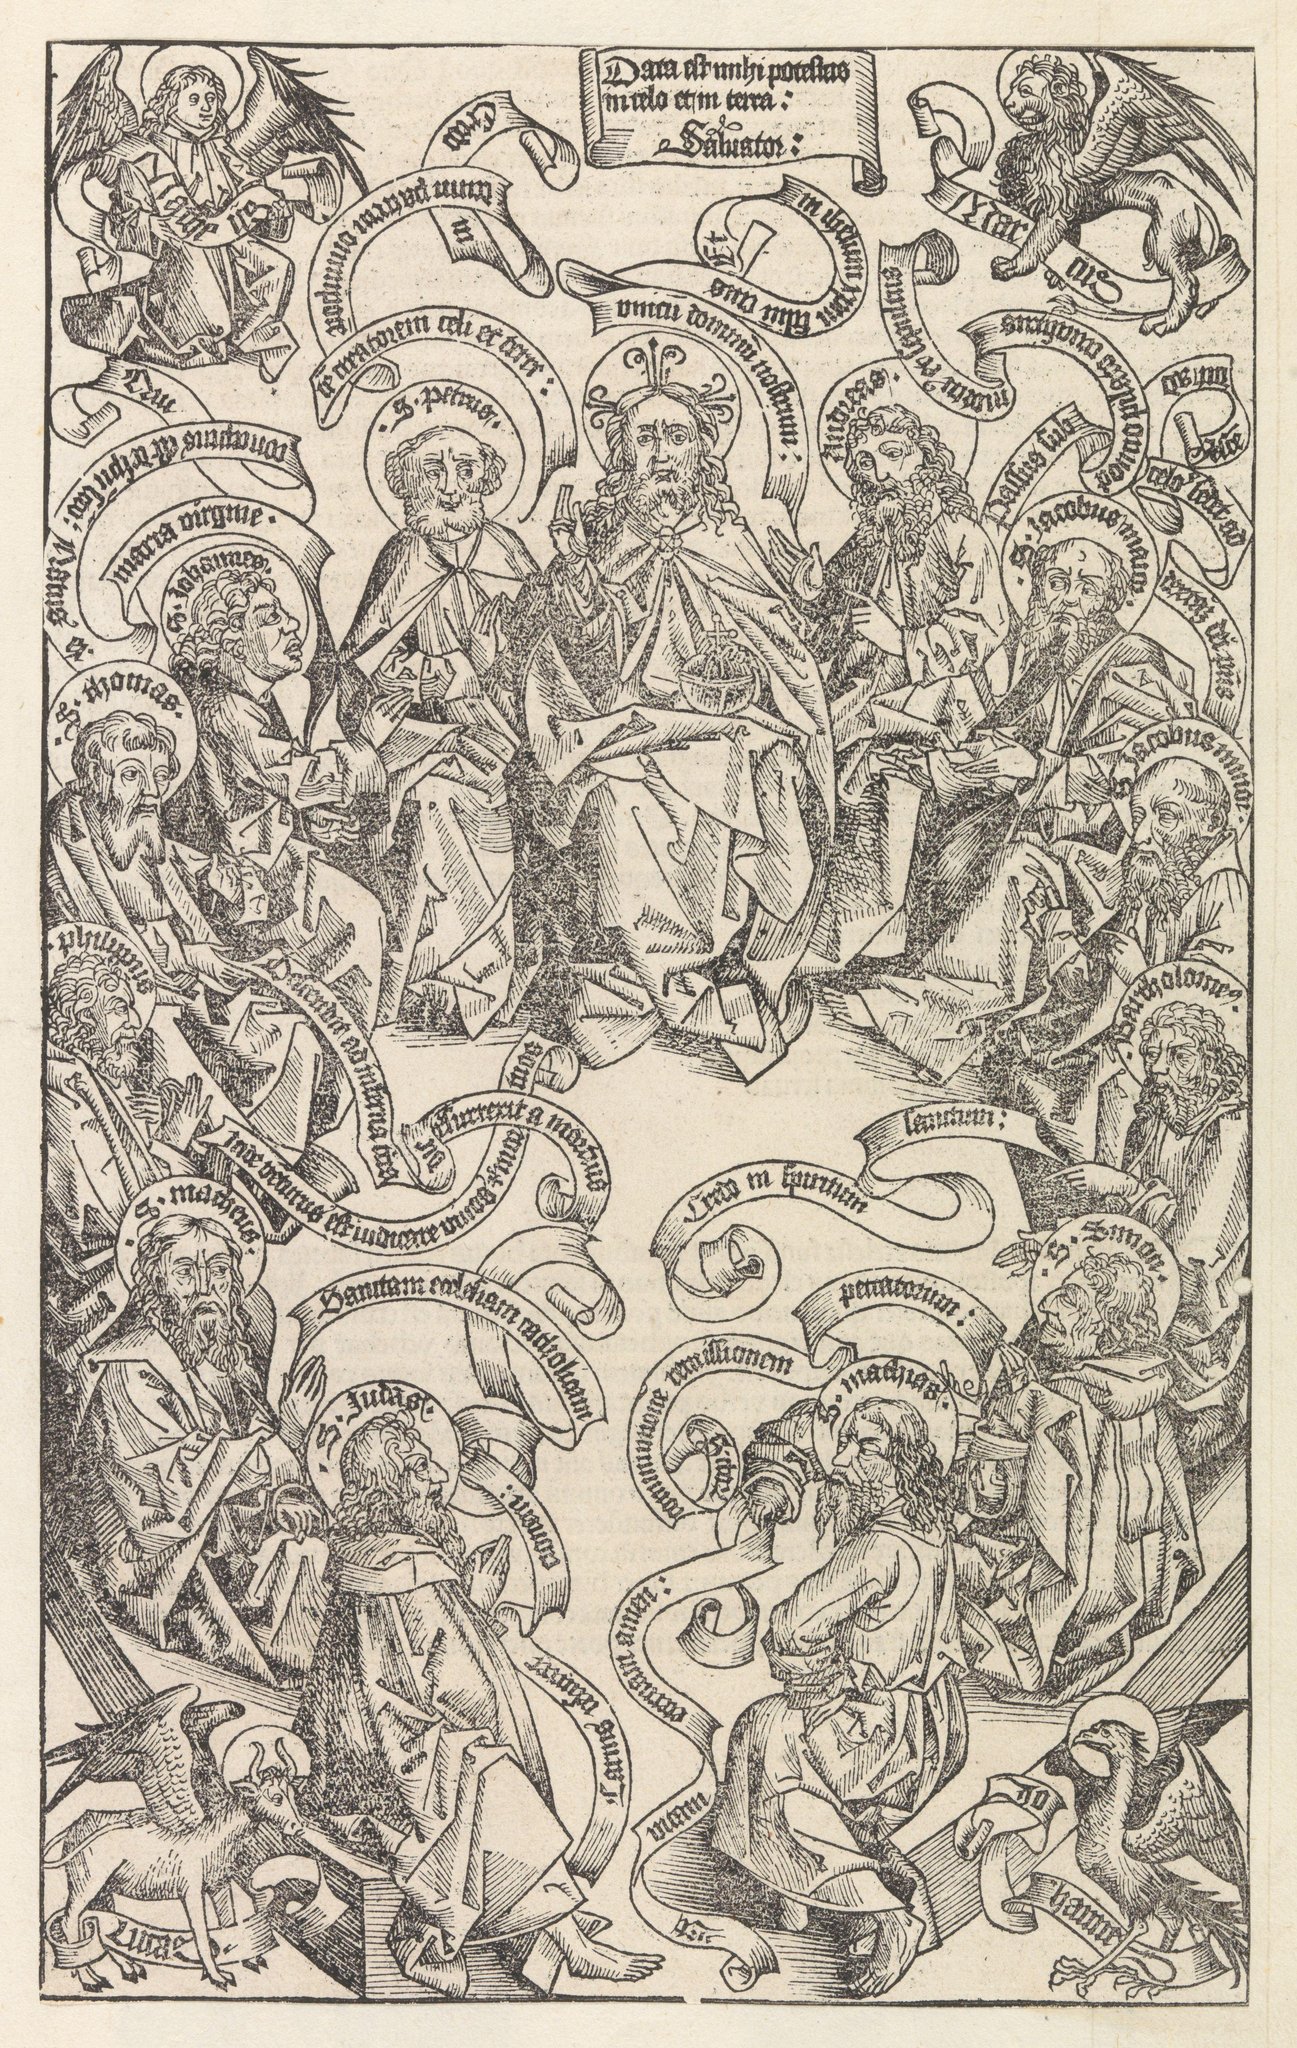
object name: album leaf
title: Liber Chronicarum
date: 1493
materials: paper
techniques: letterpress printing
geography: nuremberg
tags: eagle (possibly with book) ~ symbol of st. john, ox (possibly with book) ~ symbol of st. luke, lion (possibly with book) ~ symbol of st. mark, angel (possibly with book) ~ symbol of st. matthew, adult christ together with apostles, evangelists, saints, etc., creed, credo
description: Christus zit met de rijksappel op zijn rechter knie in een kring met de twaalf apostelen. Elke apostel heeft een nimbus met zijn naam. Christus heeft een kruisnimbus. Links en rechts van Christus zitten Petrus en Andreas. Midden boven de tekst: Data est mihi potestas in caelo et in terra: Salvator (Mat. 28:18). De banderollen bij de apostelen bevatten de twaalf artikelen van het Credo. In de hoeken van de voorstelling de symbolen van de vier Evangelisten. De prent maakt deel uit van een album.